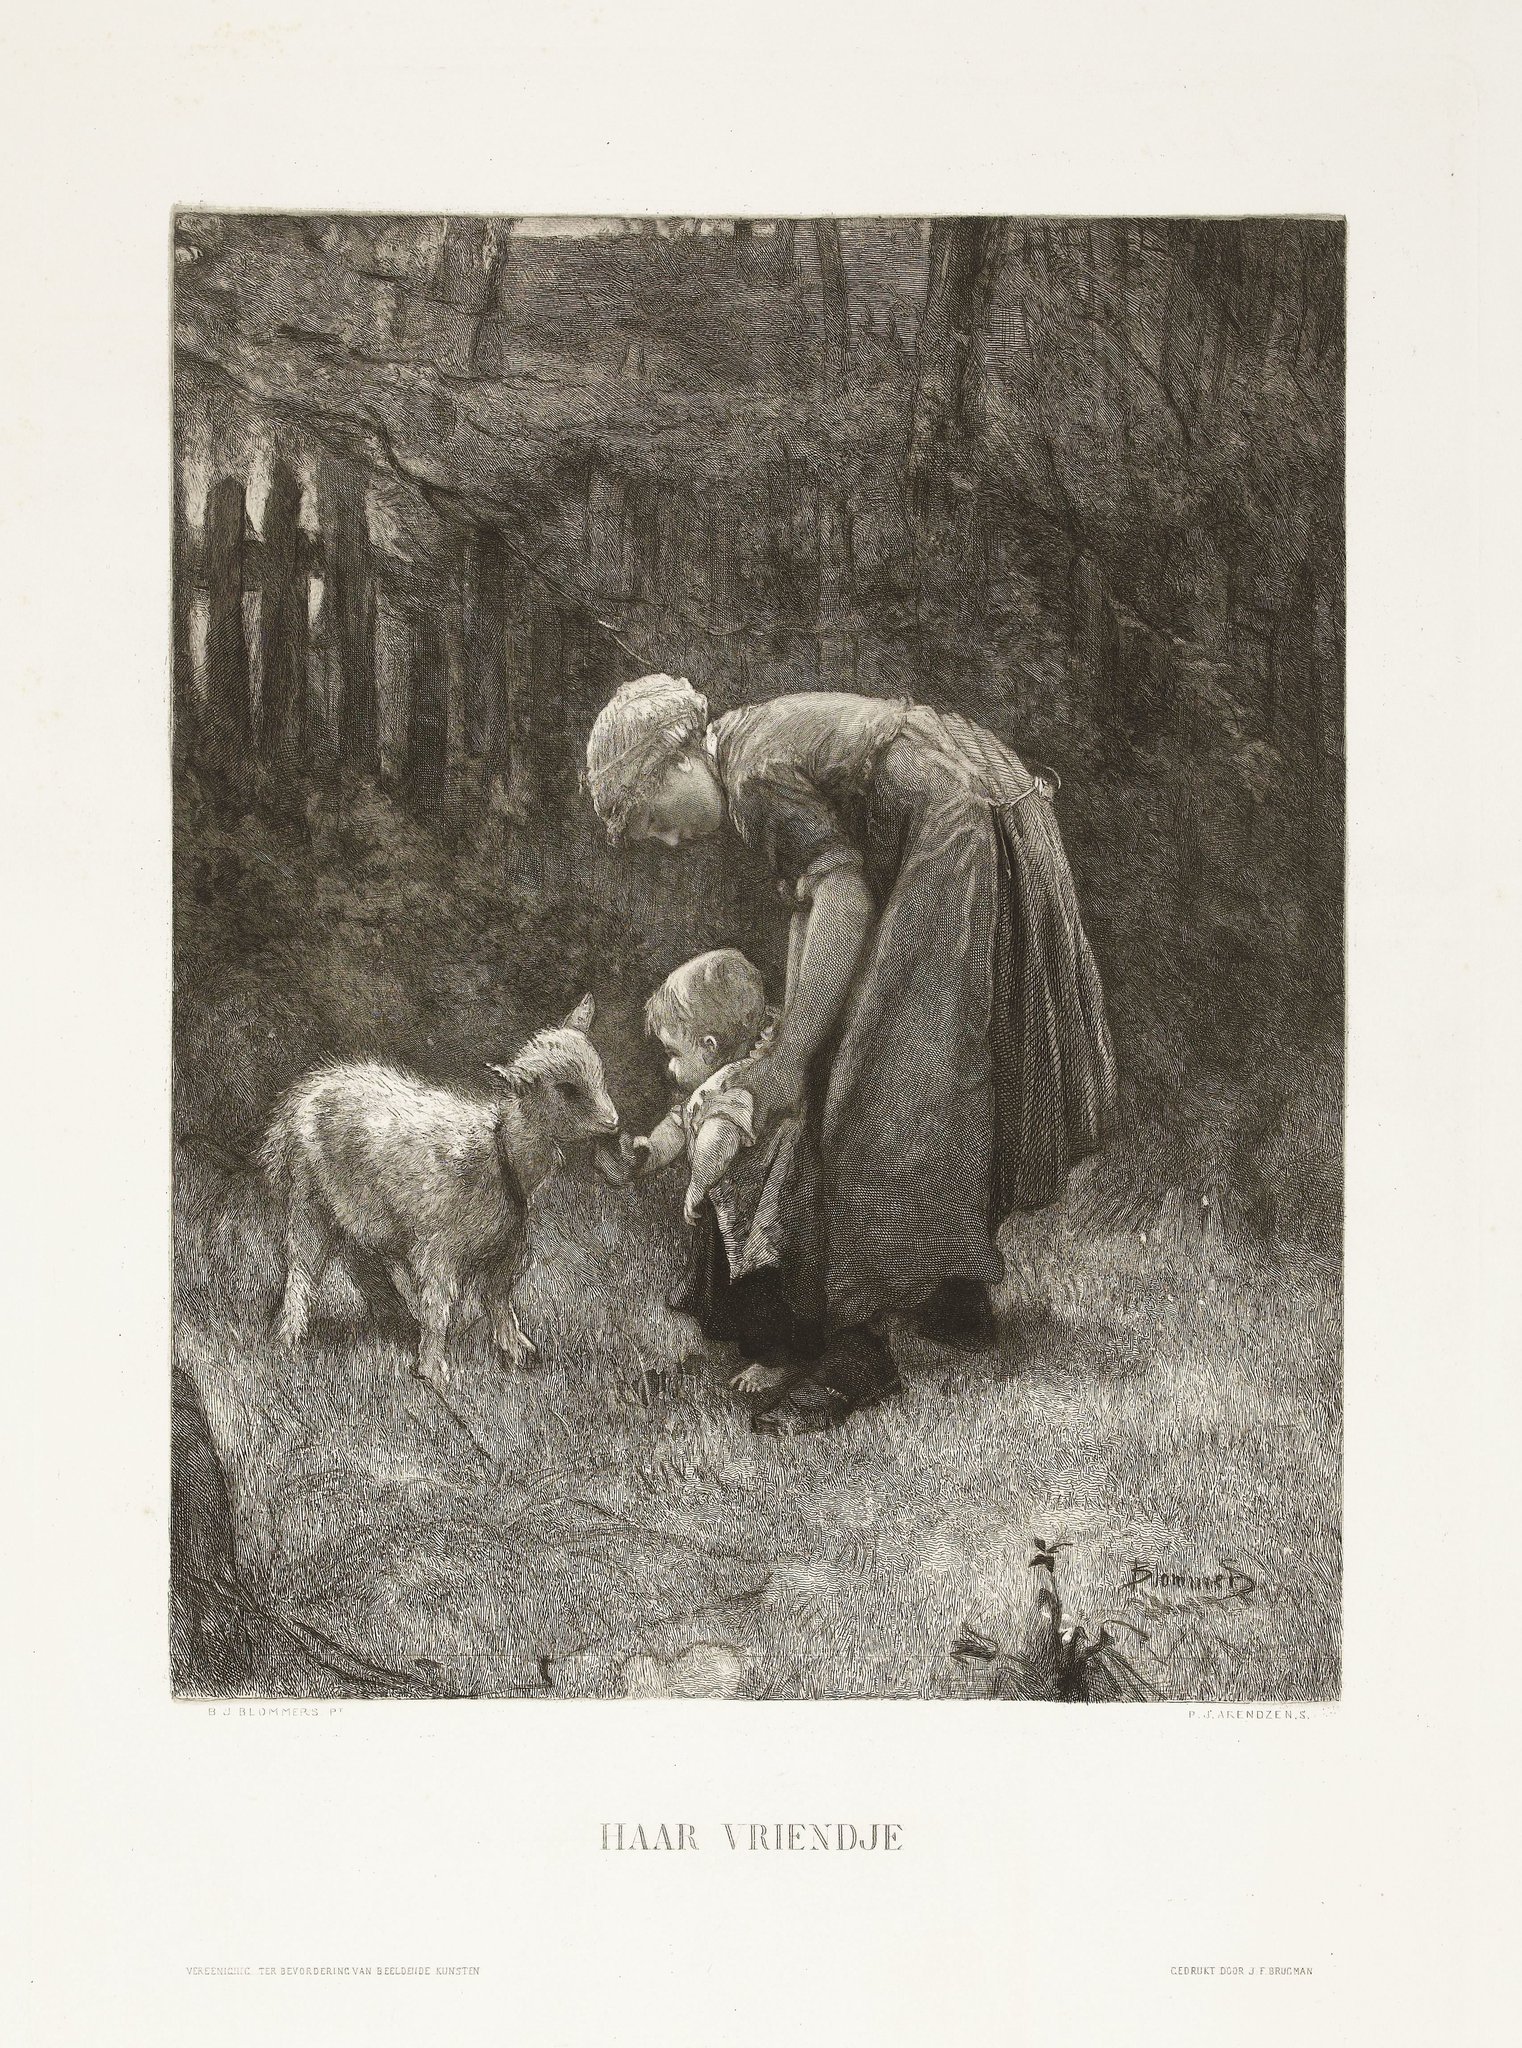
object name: print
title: Haar vriendje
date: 1865-1879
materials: paper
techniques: etching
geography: amsterdam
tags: child playing with animals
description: Een boerenmeisje houdt een kleuter vast die net kan lopen. Het kindje voert een jonge geit.